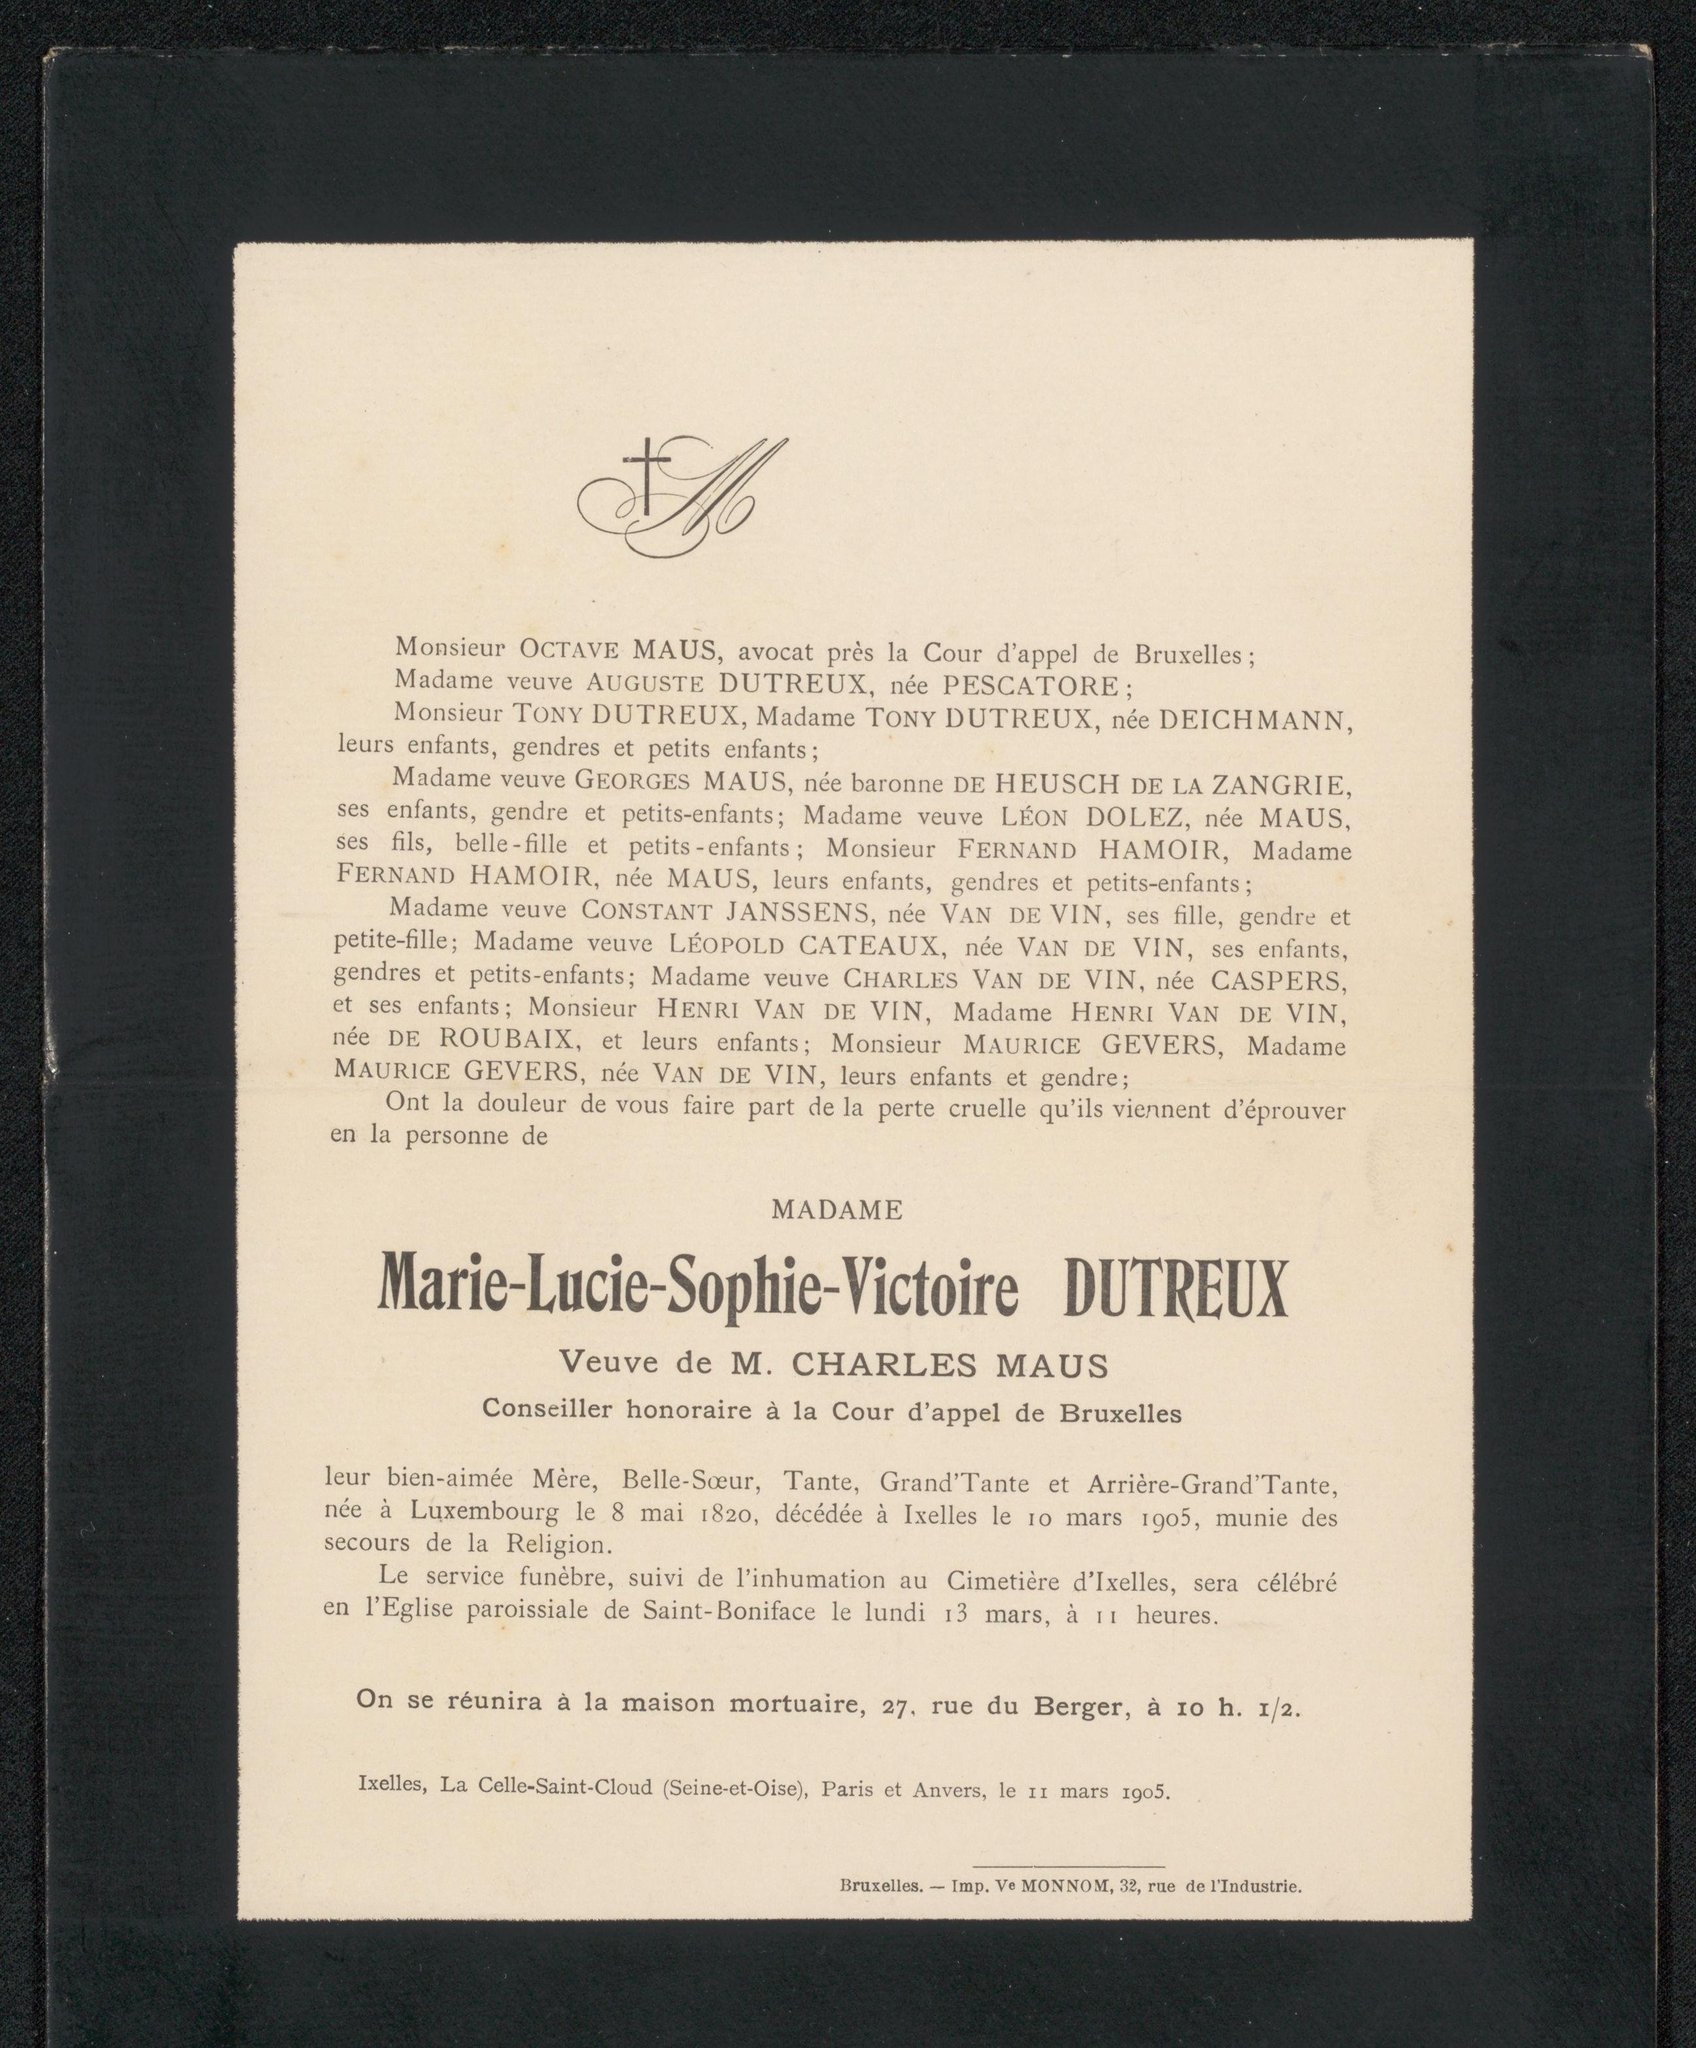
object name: overlijdensbericht, overlijdensadvertentie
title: Overlijdensbericht aan Philip Zilcken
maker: Anonymous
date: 1905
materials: paper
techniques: printing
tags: painter, draughtsman, philip zilcken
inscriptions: collector's mark: ‘RPK’